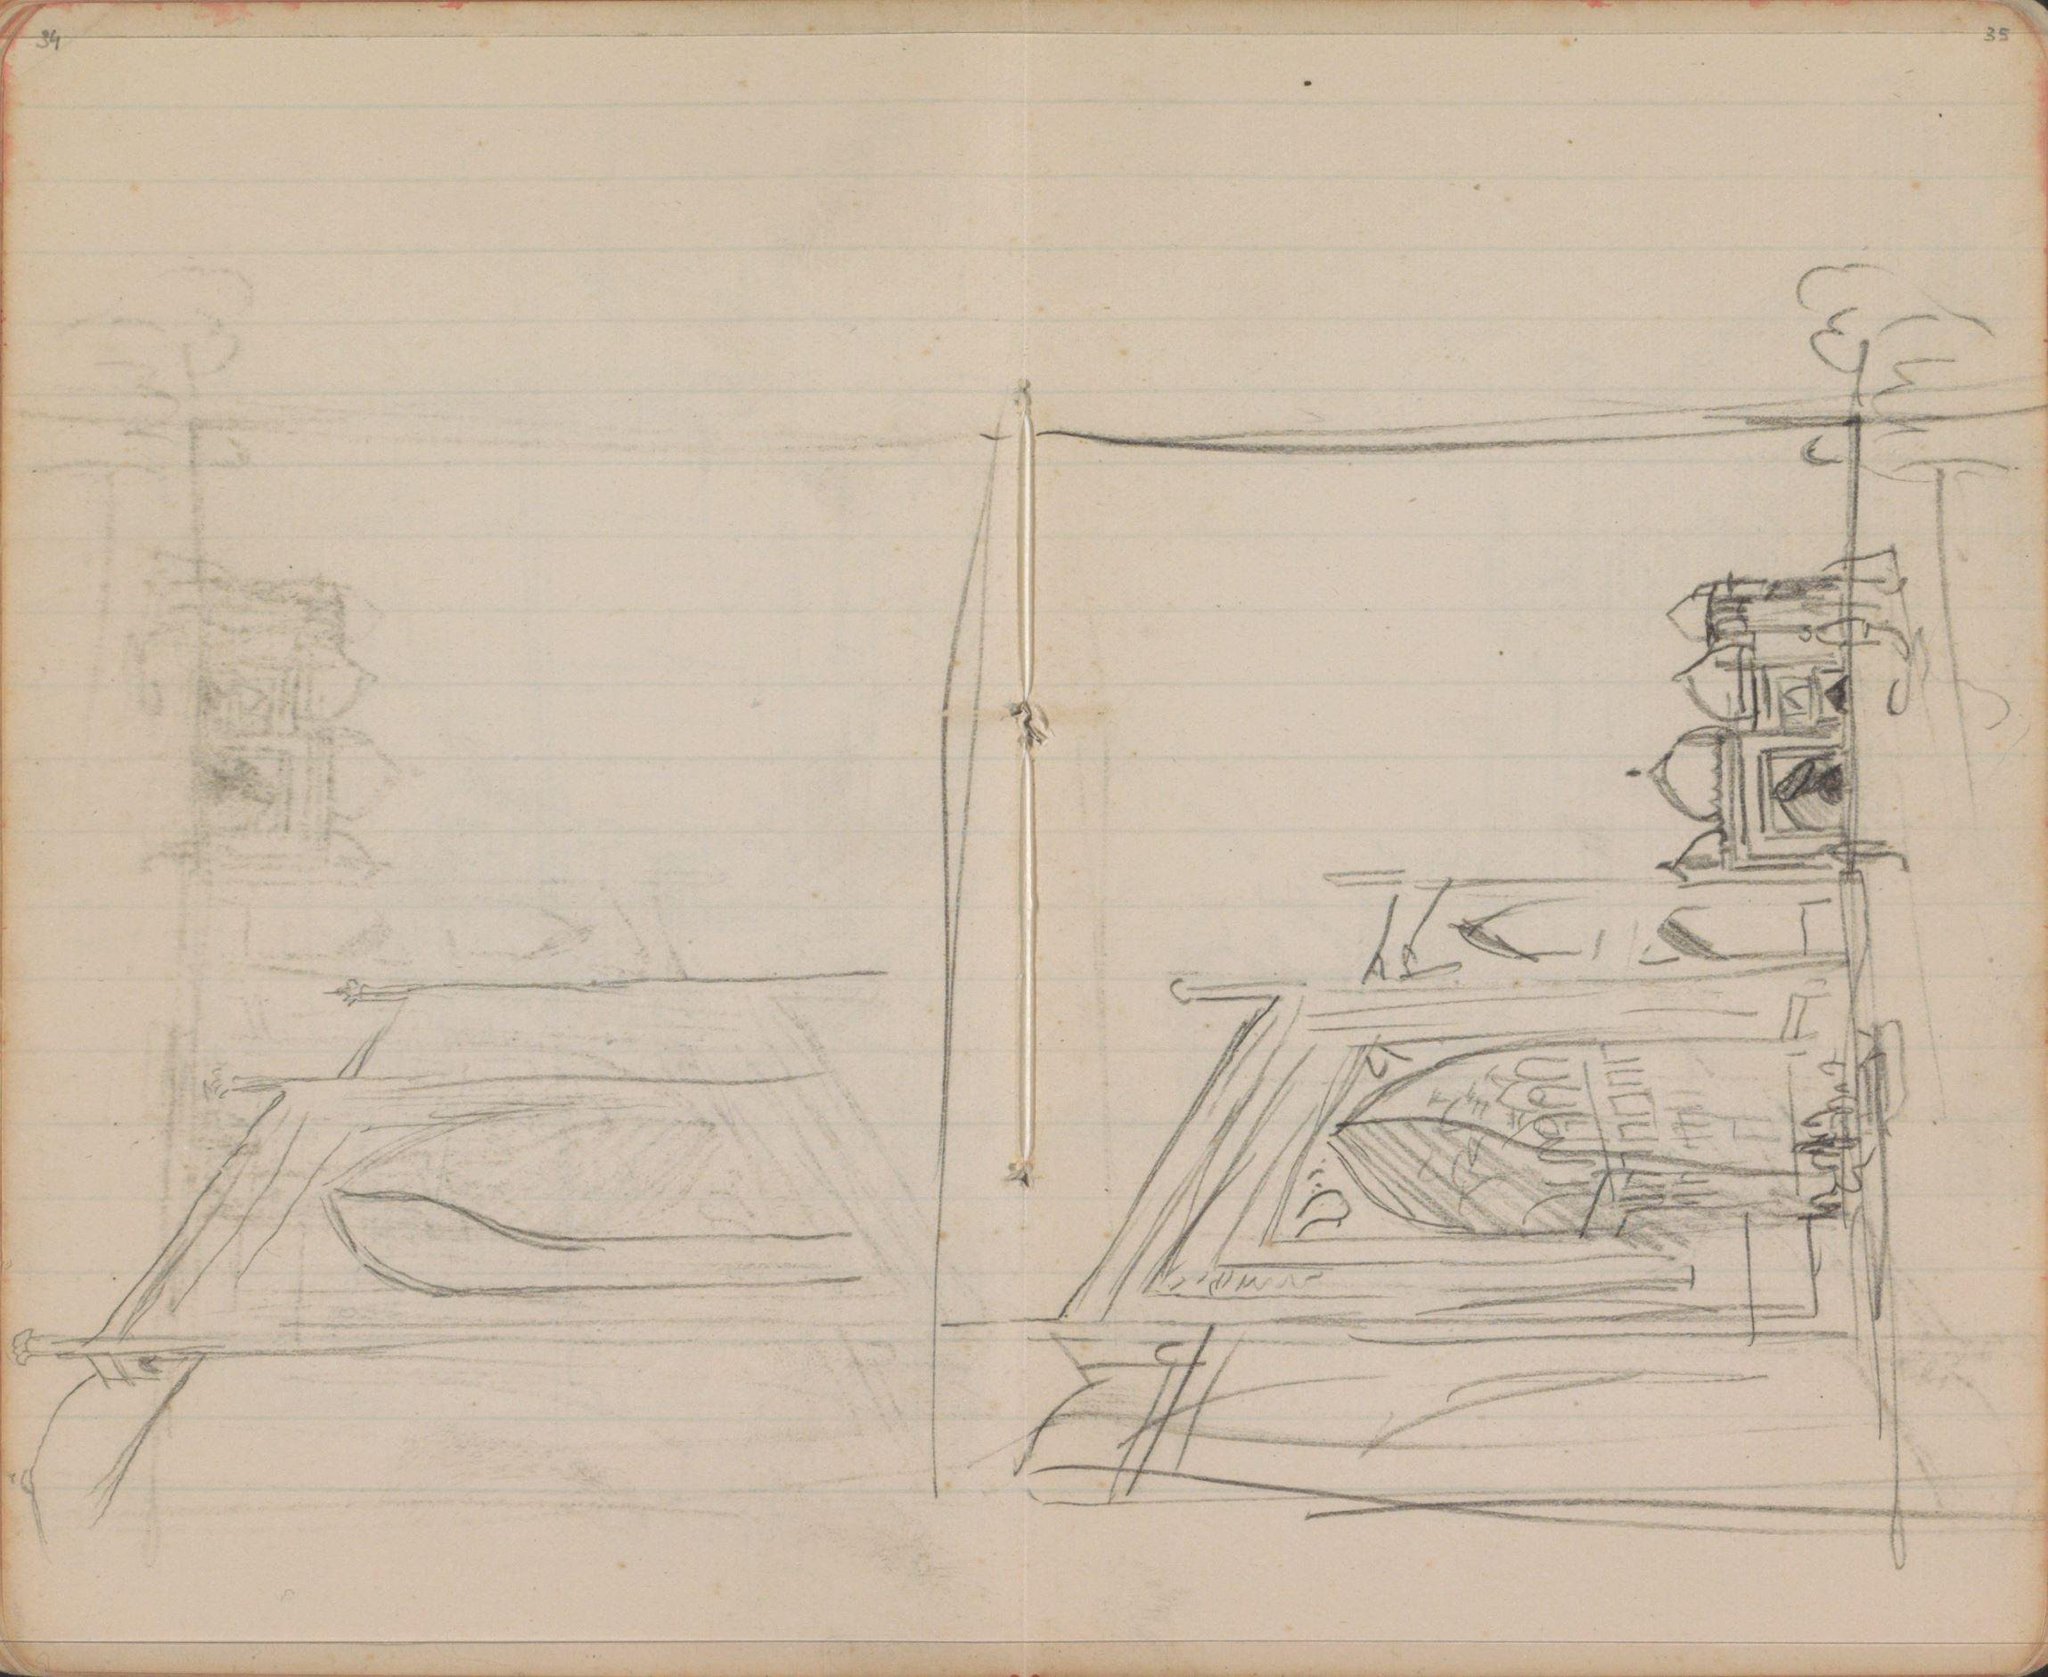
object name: sketchbook leaf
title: Zijaanzicht van de Taj Mahal, met uitzicht op de moskee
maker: marius bauer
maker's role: draughtsman, print maker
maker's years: 1867-1932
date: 1897-1898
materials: chalk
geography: agra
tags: mausoleum, temple, shrine ~ islam, mohammedanism, exterior ~ representation of a building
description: Pagina 34 en 35 uit een schetsboek met 36 bladen.